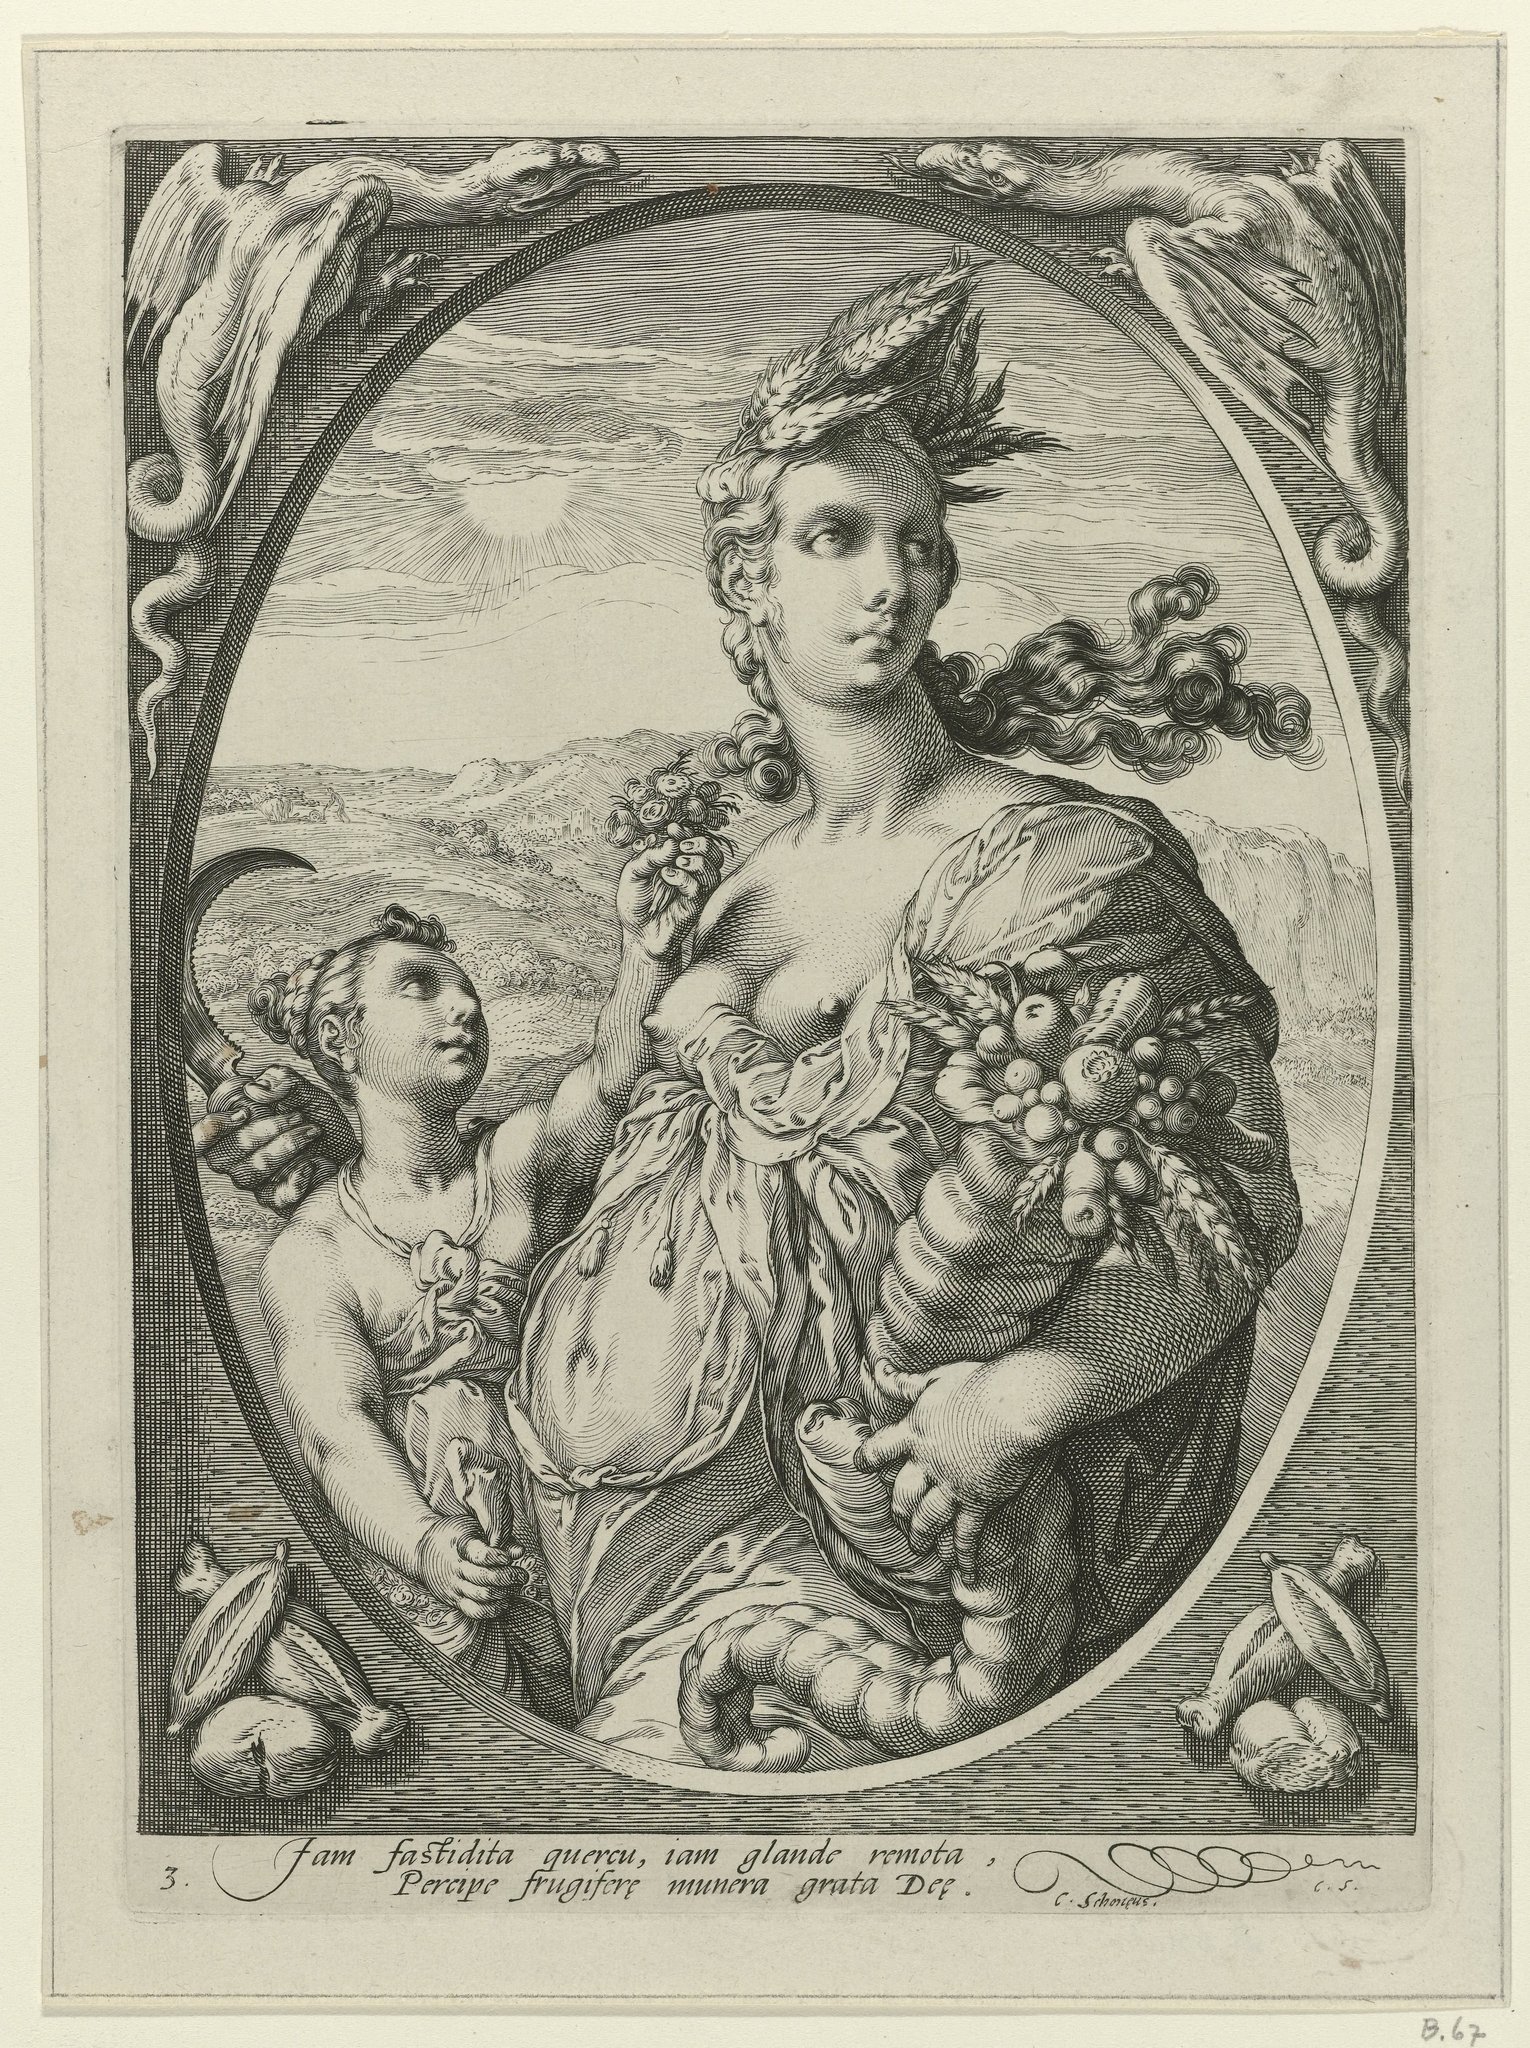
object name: print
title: Ceres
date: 1575-1607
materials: paper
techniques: engraving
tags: (story of) ceres (demeter)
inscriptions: collector's mark: Lugt 240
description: Ceres als belichaming van de overvloed der aarde. Op haar hoofd draagt ze een kroon van korenaren, in haar arm heeft ze de hoorn des overvloeds en in haar hand een sikkel. Naast haar staat haar dochter Proserpina. De bovenhoeken van de lijst zijn versierd met twee draken, de onderhoeken met landbouwproducten.